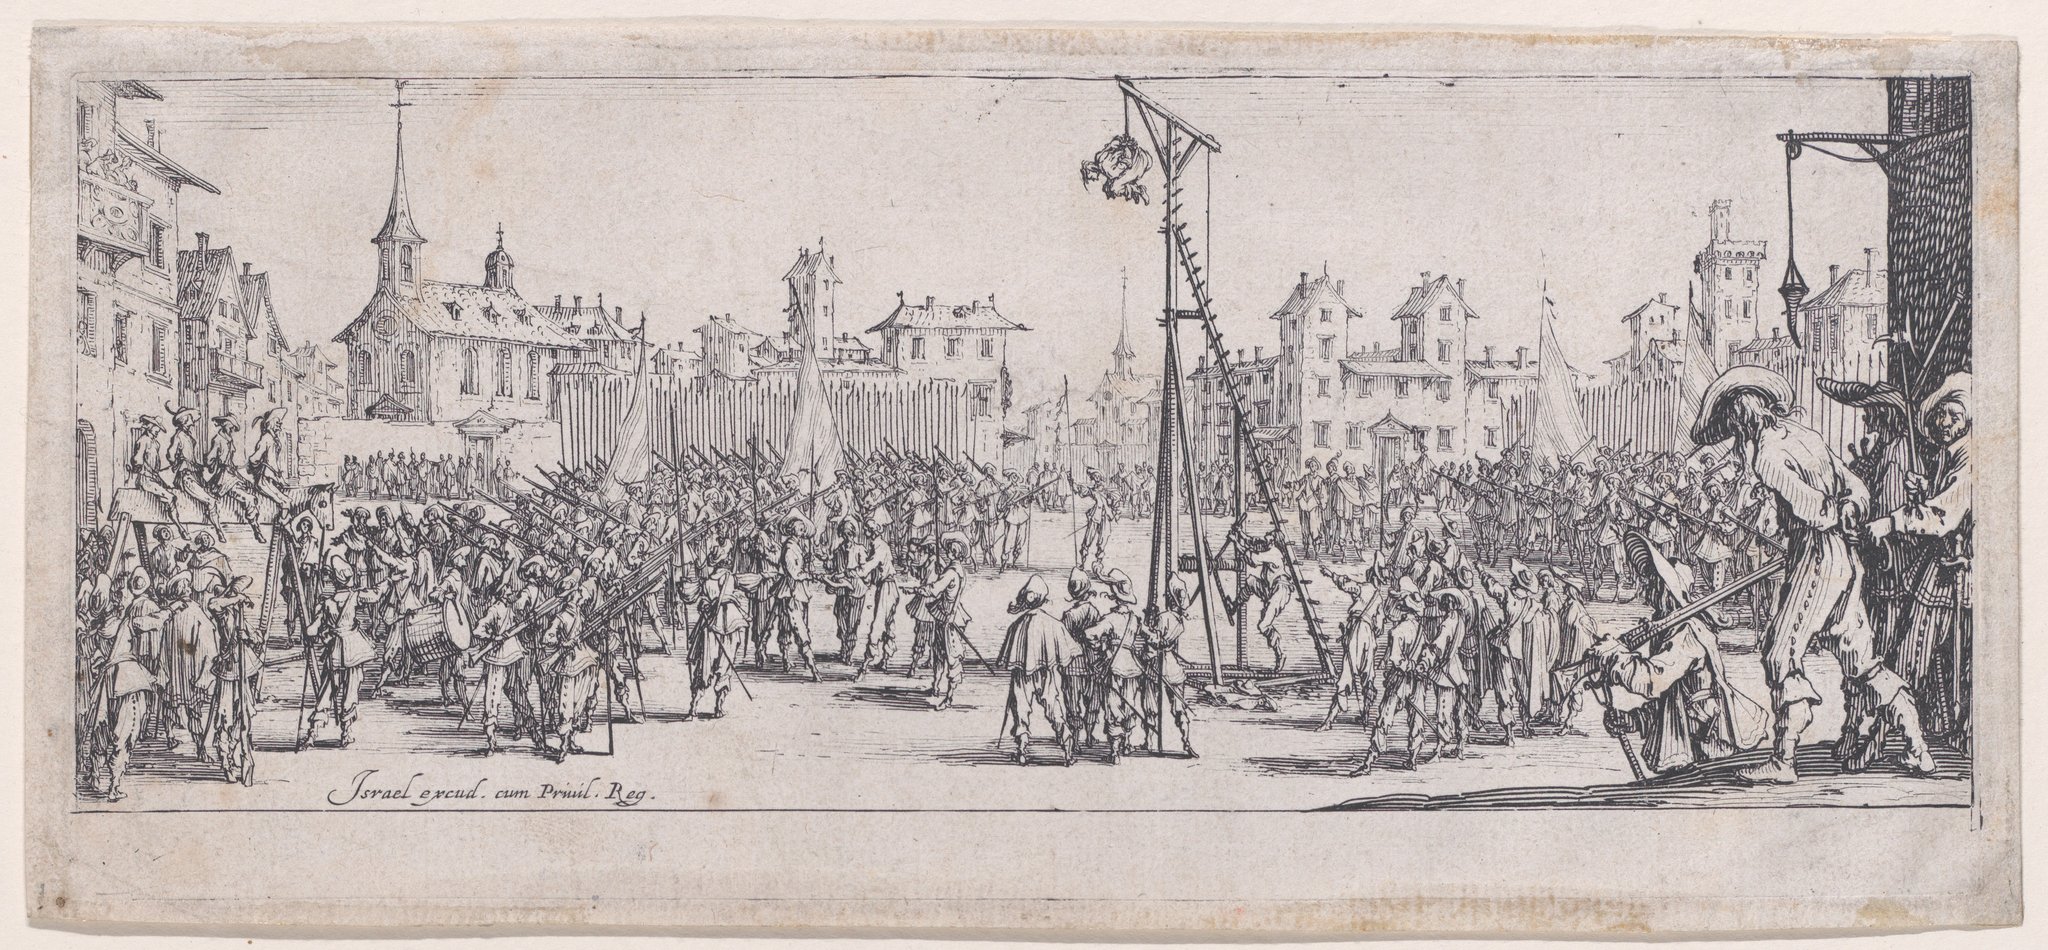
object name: print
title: L'Estrapade (Strappado), from Les Misères et les Mal-Heures de la Guerre (The Miseries and Misfortunes of War), plate 10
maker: jacques callot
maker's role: artist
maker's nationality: french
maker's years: 1592-1635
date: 1633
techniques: etching